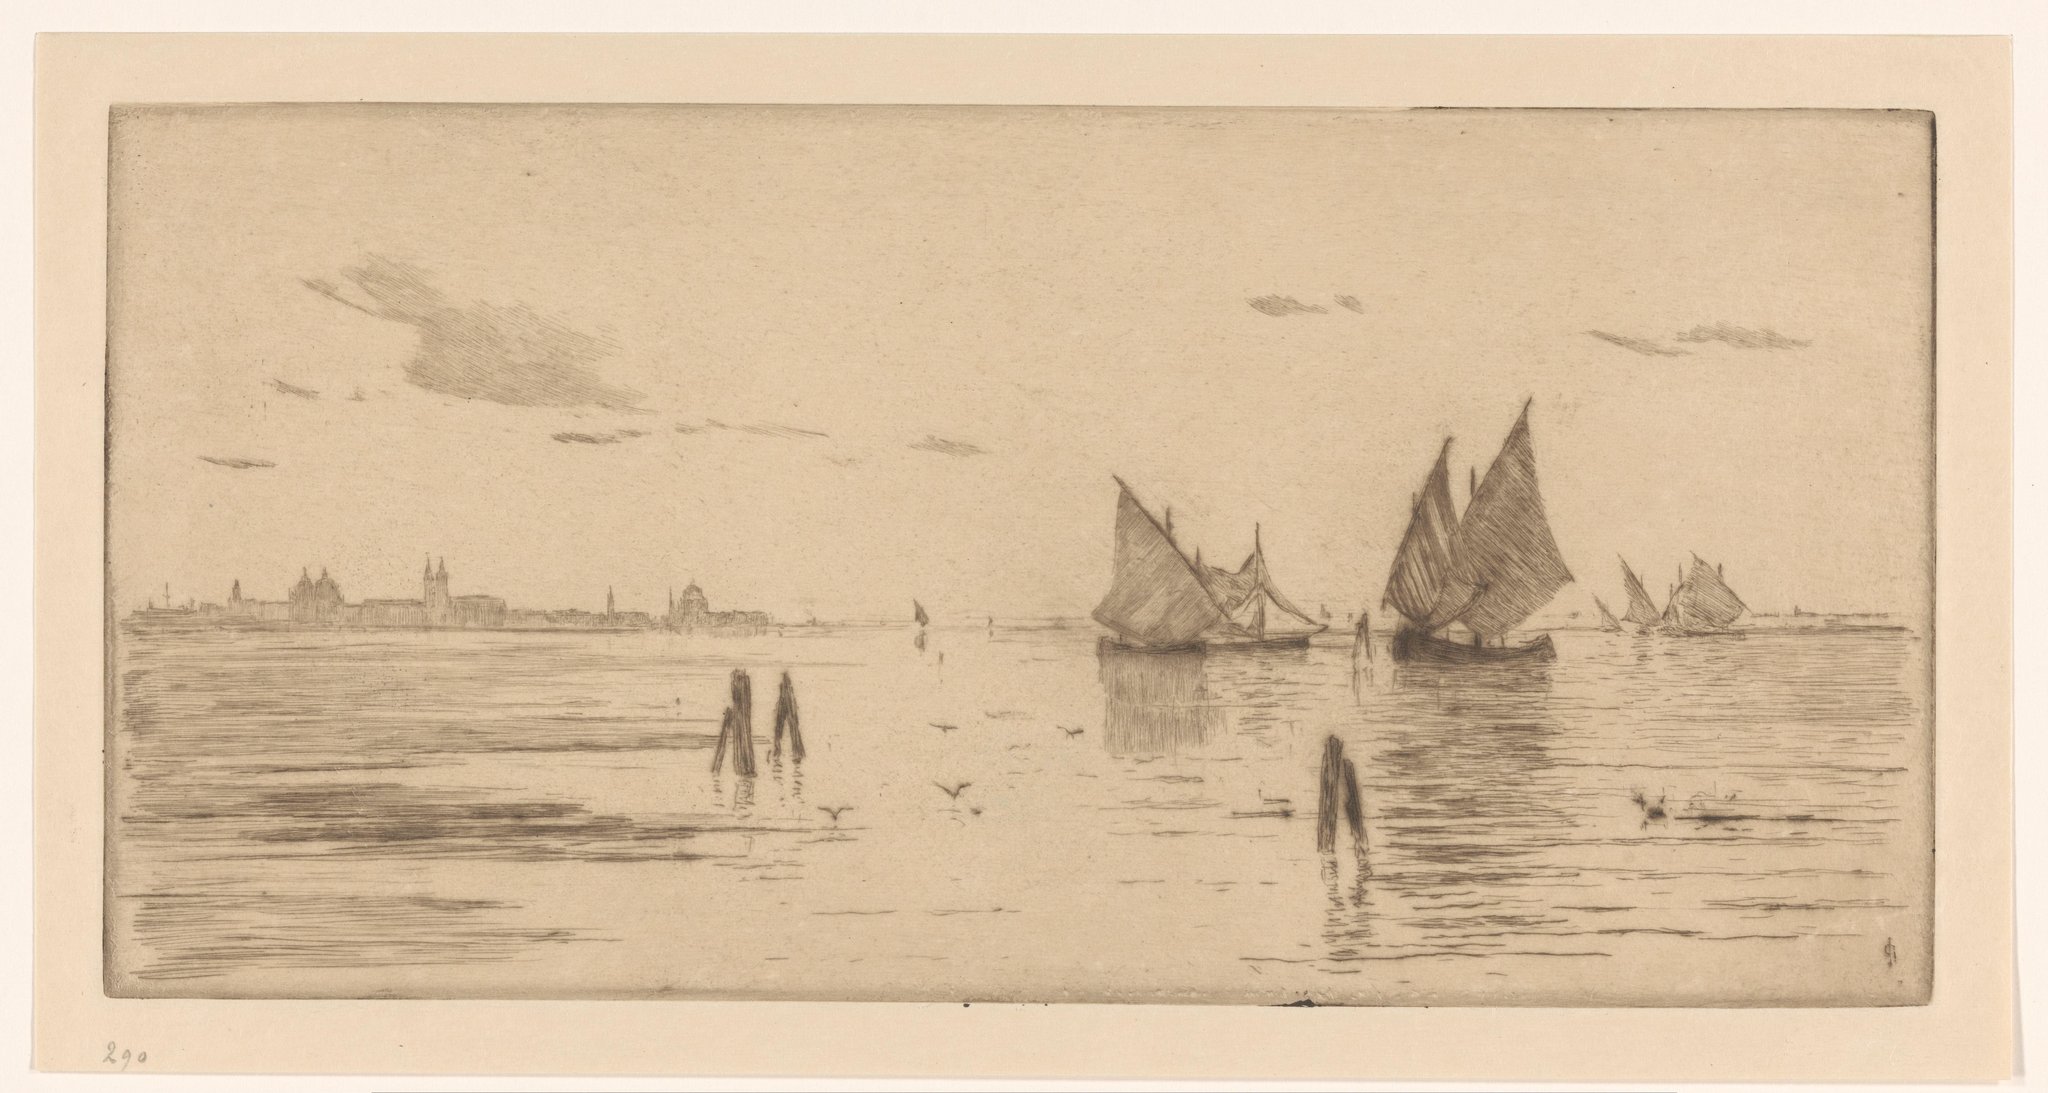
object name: print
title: Vissersboten in de Lagune van Venetië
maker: carel nicolaas storm van s-gravesande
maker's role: draughtsman, print maker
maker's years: 1841-1924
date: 1851-1902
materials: paper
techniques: drypoint, intaglio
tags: haff, lagoon created by sand, shingle bank ~ coast, prospect of city, town panorama, silhouette of city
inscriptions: number: ‘290’, collector's mark: Lugt 2228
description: Mogelijk vermeld in: Storm van 's-Gravesande, Charles. Catalogue des eaux-fortes et lithographies. New York: s.n., 1903, of in een onbekende latere uitgave van het manuscript. Vermoedelijk vermeld als catalogusnummer 290.